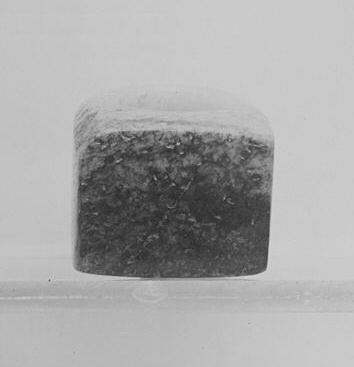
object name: archer's ring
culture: chinese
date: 1644-1911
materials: jade